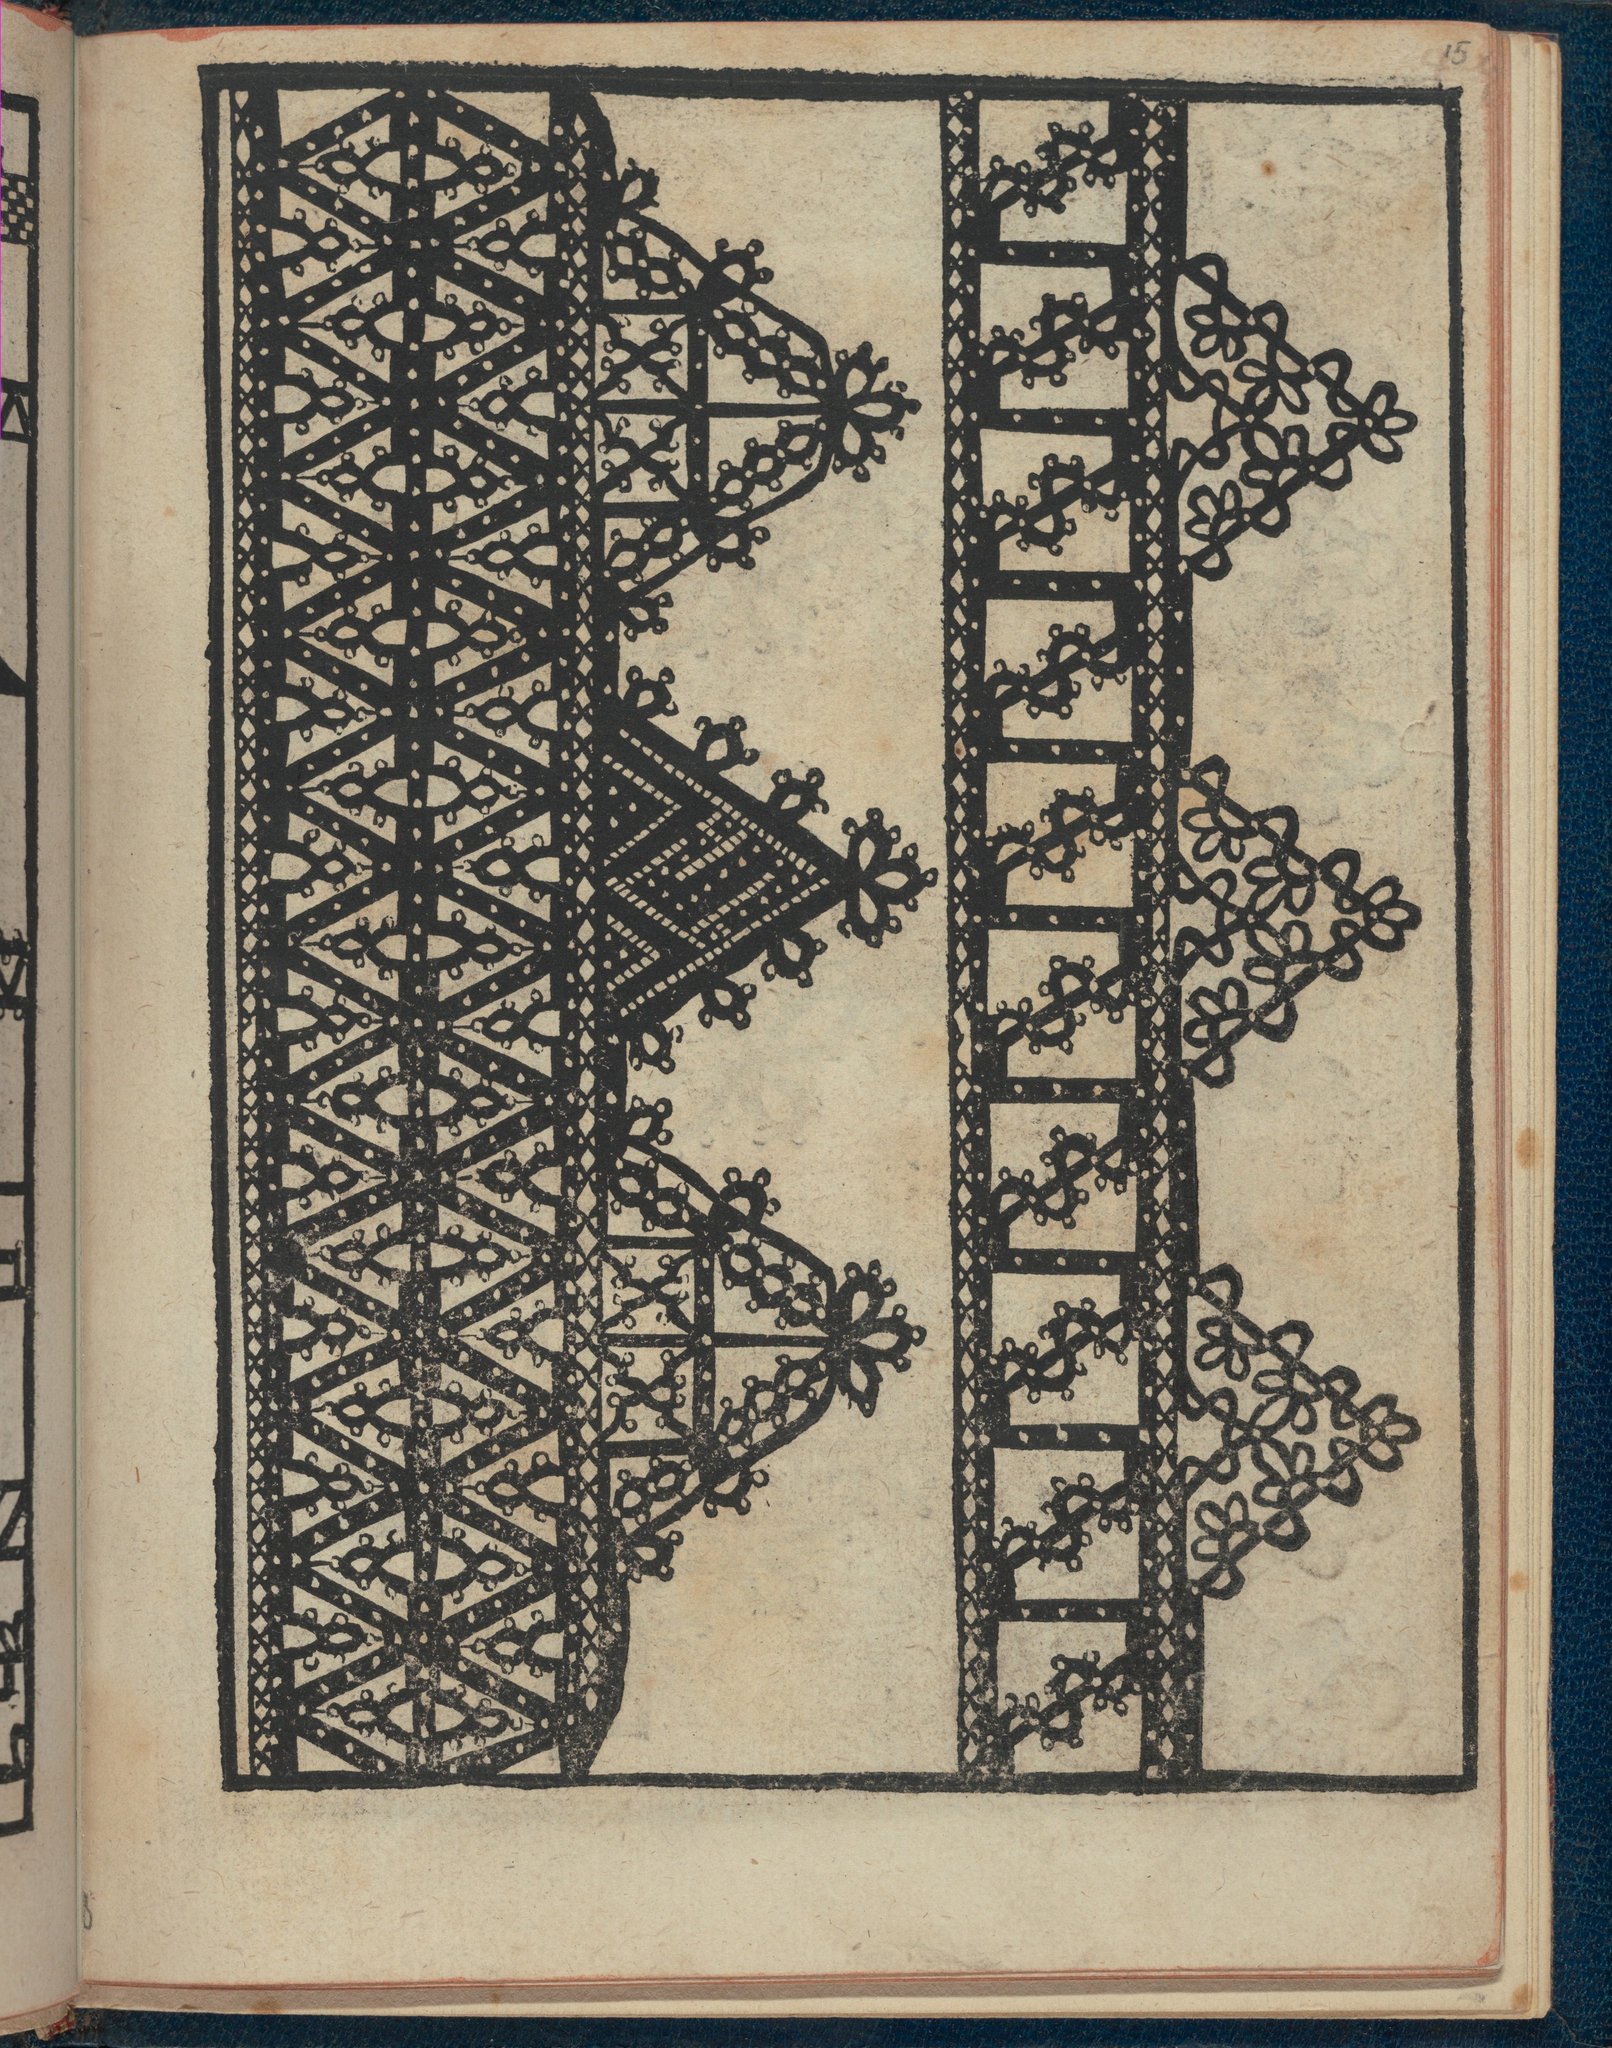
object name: book print ornament architecture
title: Le Pompe: Opera Nova, page 8 (recto)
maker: giovanni battista & marchio sessa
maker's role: publisher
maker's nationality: italian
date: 1557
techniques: woodcut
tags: ornament